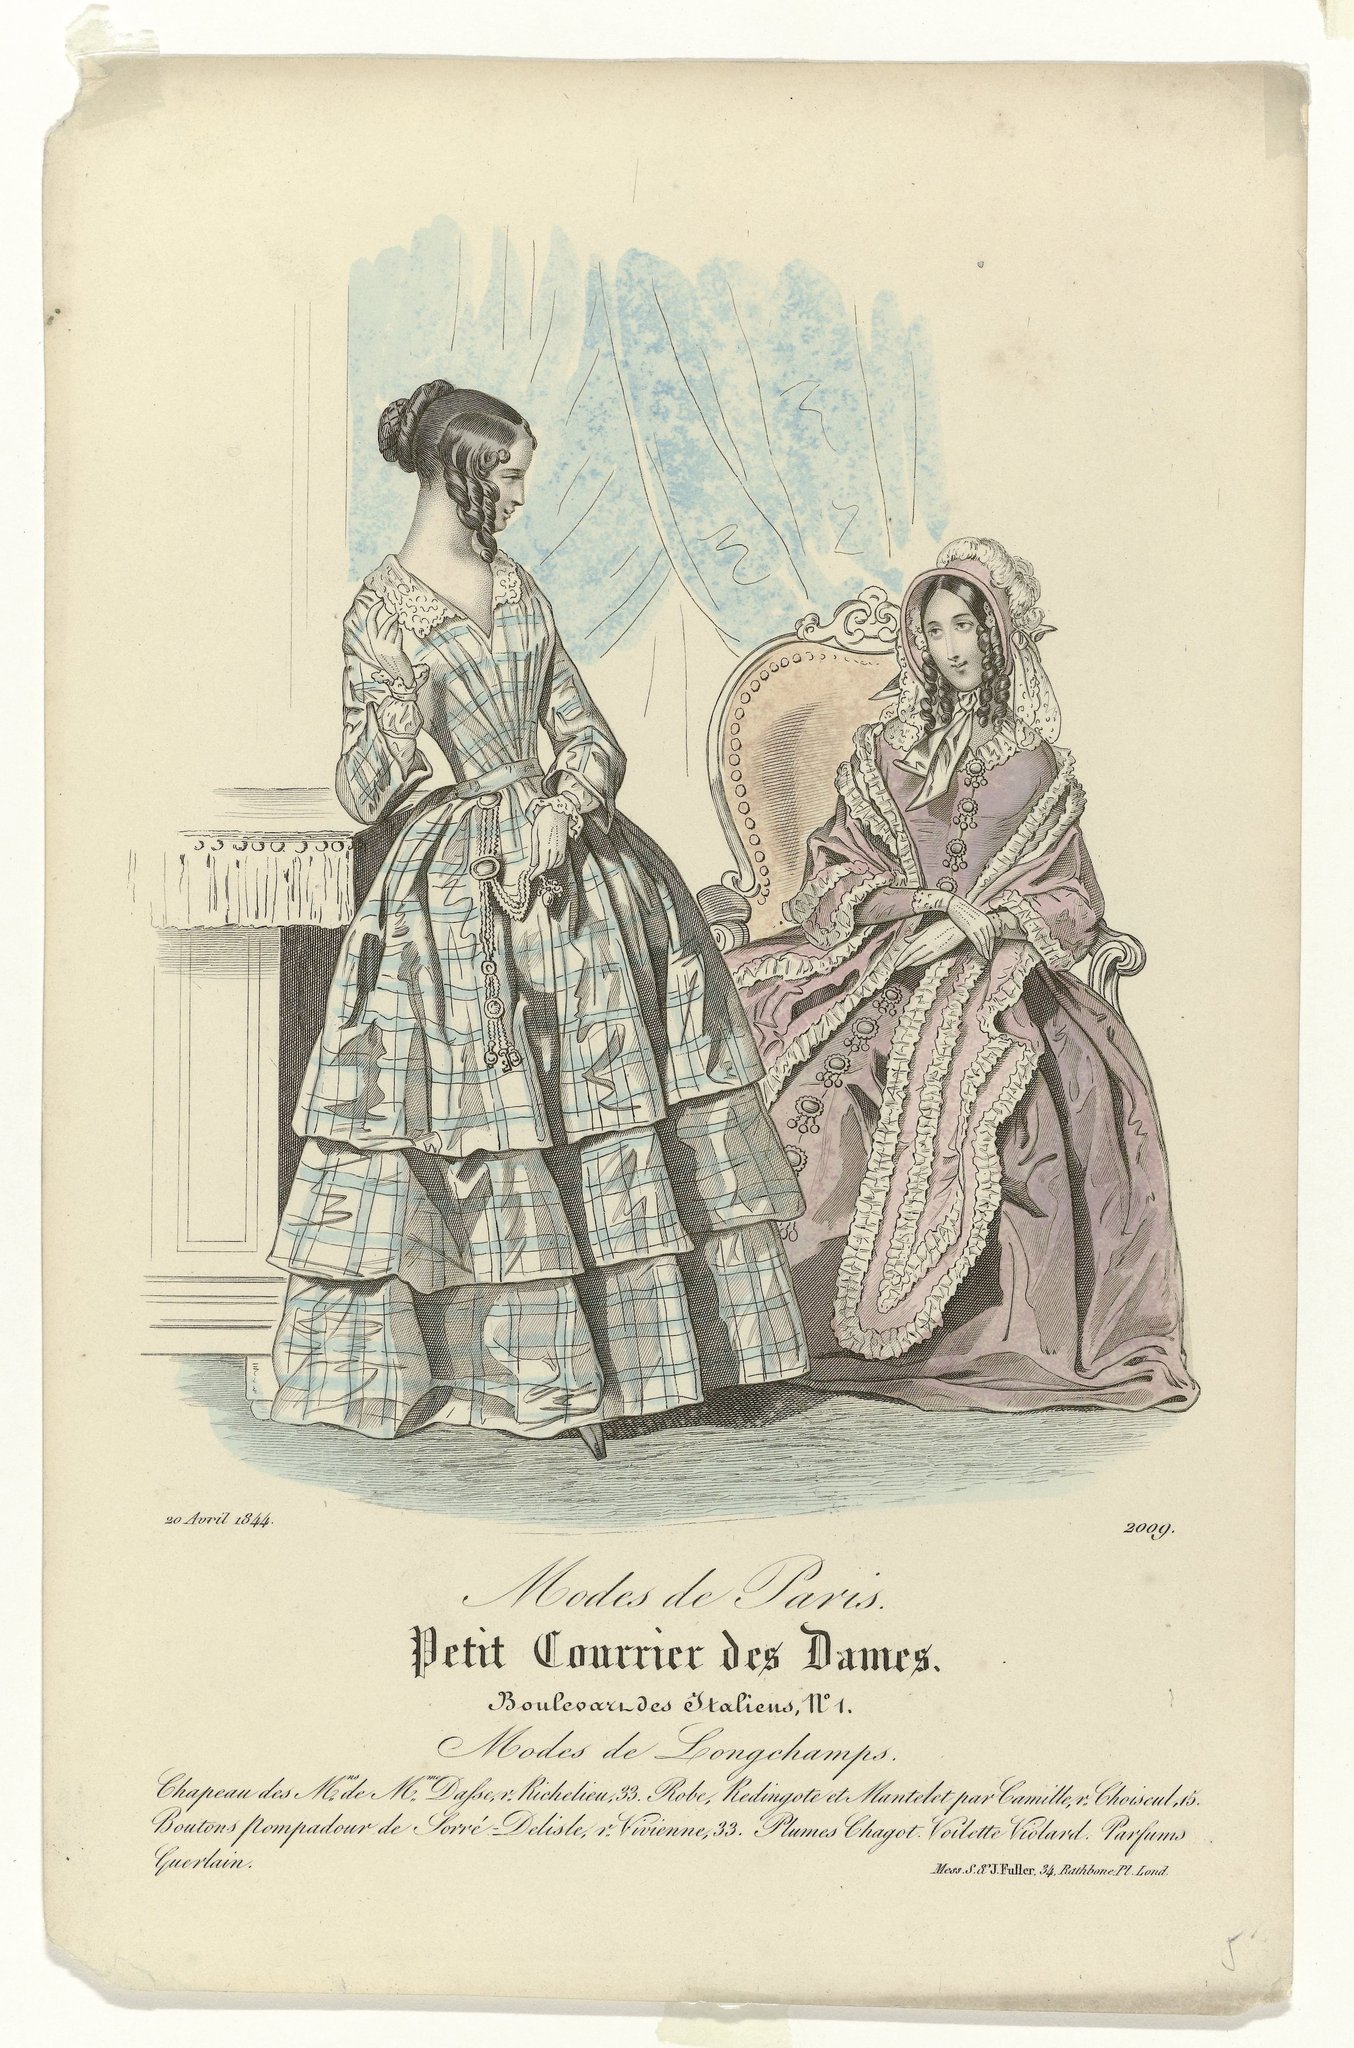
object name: fashion print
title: Petit Courrier des Dames, 20 avril 1844, No. 2009 : Chapeau des Mns de Mme Dass (...)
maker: Anonymous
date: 1844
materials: paper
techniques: engraving, hand coloring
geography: london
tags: veil (+ women's clothes), button (+ women's clothes), dress, gown: redingote (+ women's clothes), clothing for the upper part of the body (mantelet) (+ women's clothes), fashion plates, head-gear: hat (+ women's clothes), gloves, mittens, etc. (+ women's clothes), dress, gown (+ women's clothes)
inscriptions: address: ‘Boulevart des Italiens, No 1. / Mess. S. & J. Fuller, 34, Rathbone Place, Lond.’, title: ‘Modes de Paris. / Petit Courrier des Dames.’, caption: ‘Modes de Longchamps. / Chapeau des M"ns de M"me Dasse, r"Richelieu, 33. Robe, Redingote et Mantelet par Camille, r"Choiseul, 15. Boutons pompadour de Sorré-Delisle, r" Vivienne, 33. Plumes Chagot, Violette Violard. Parfums Guerlain.’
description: Twee vrouwen in een interieur. Volgens het onderschrift: 'modes de Longchamps'. Hoed uit de winkels van Dasse. Japon, 'redingote' en kleine schoudermantel door Camille. Knopen of 'boutons pompadour' van Jorré Delisle. Hieronder enkele regels reclametekst voor verschillende producten. Prent uit het modetijdschrift Petit Courrier des Dames (1821-1868).